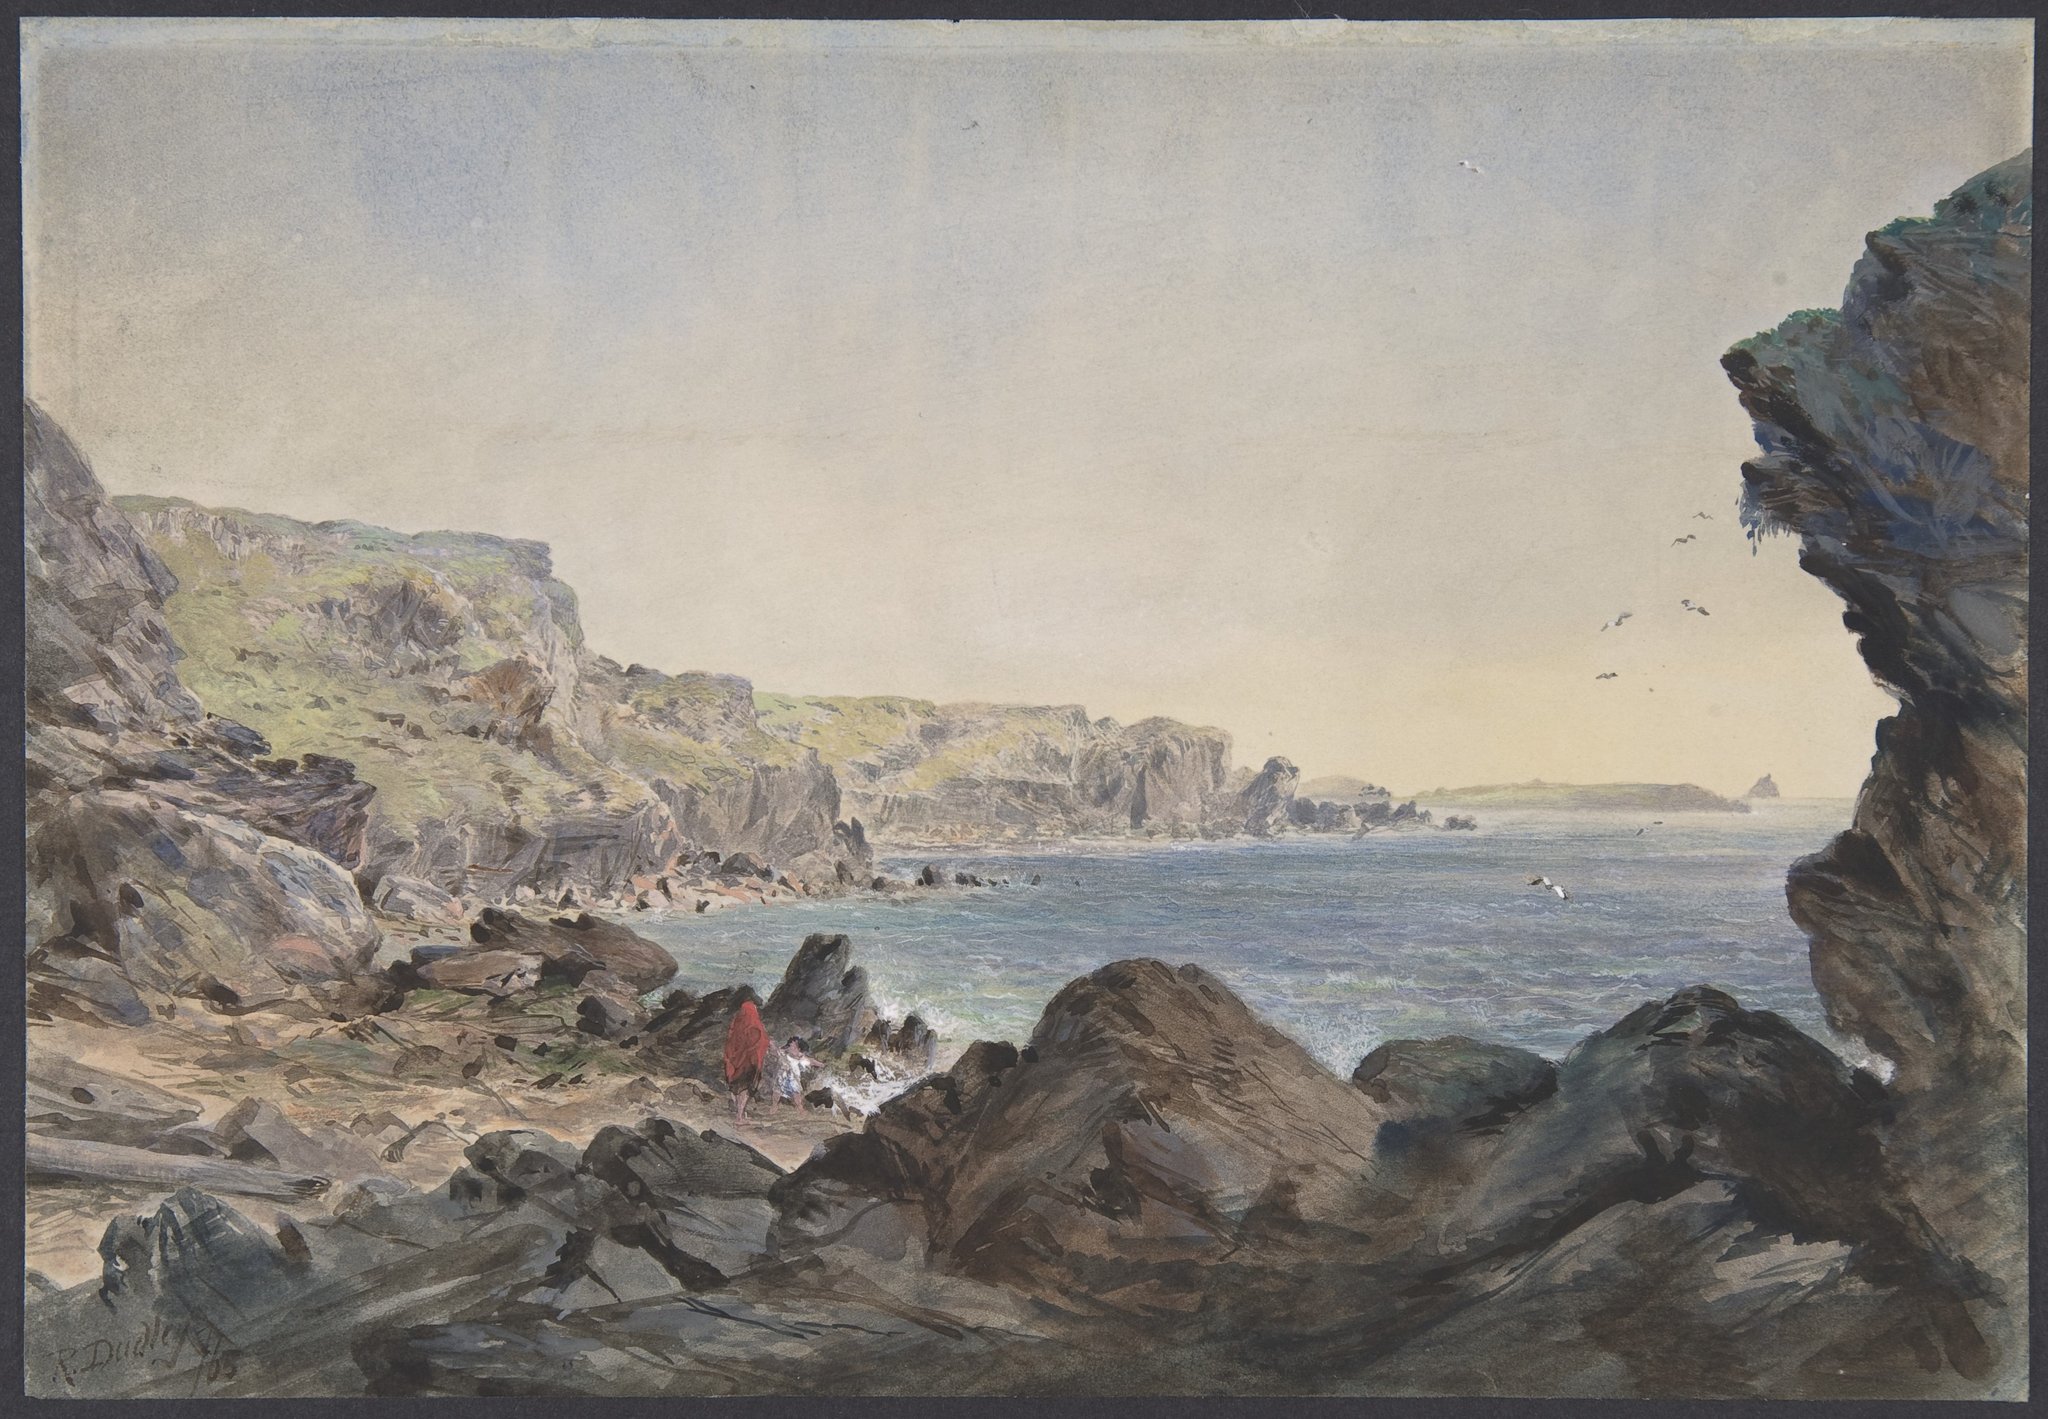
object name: drawing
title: Foilhummerum Bay, Valentia, Looking Seawards from the Point at Which the Cable Reaches the Shore of Ireland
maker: robert charles dudley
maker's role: artist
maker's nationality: british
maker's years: 1826-1909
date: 1865-1866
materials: gouache, graphite, watercolor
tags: seascapes,transatlantic cable